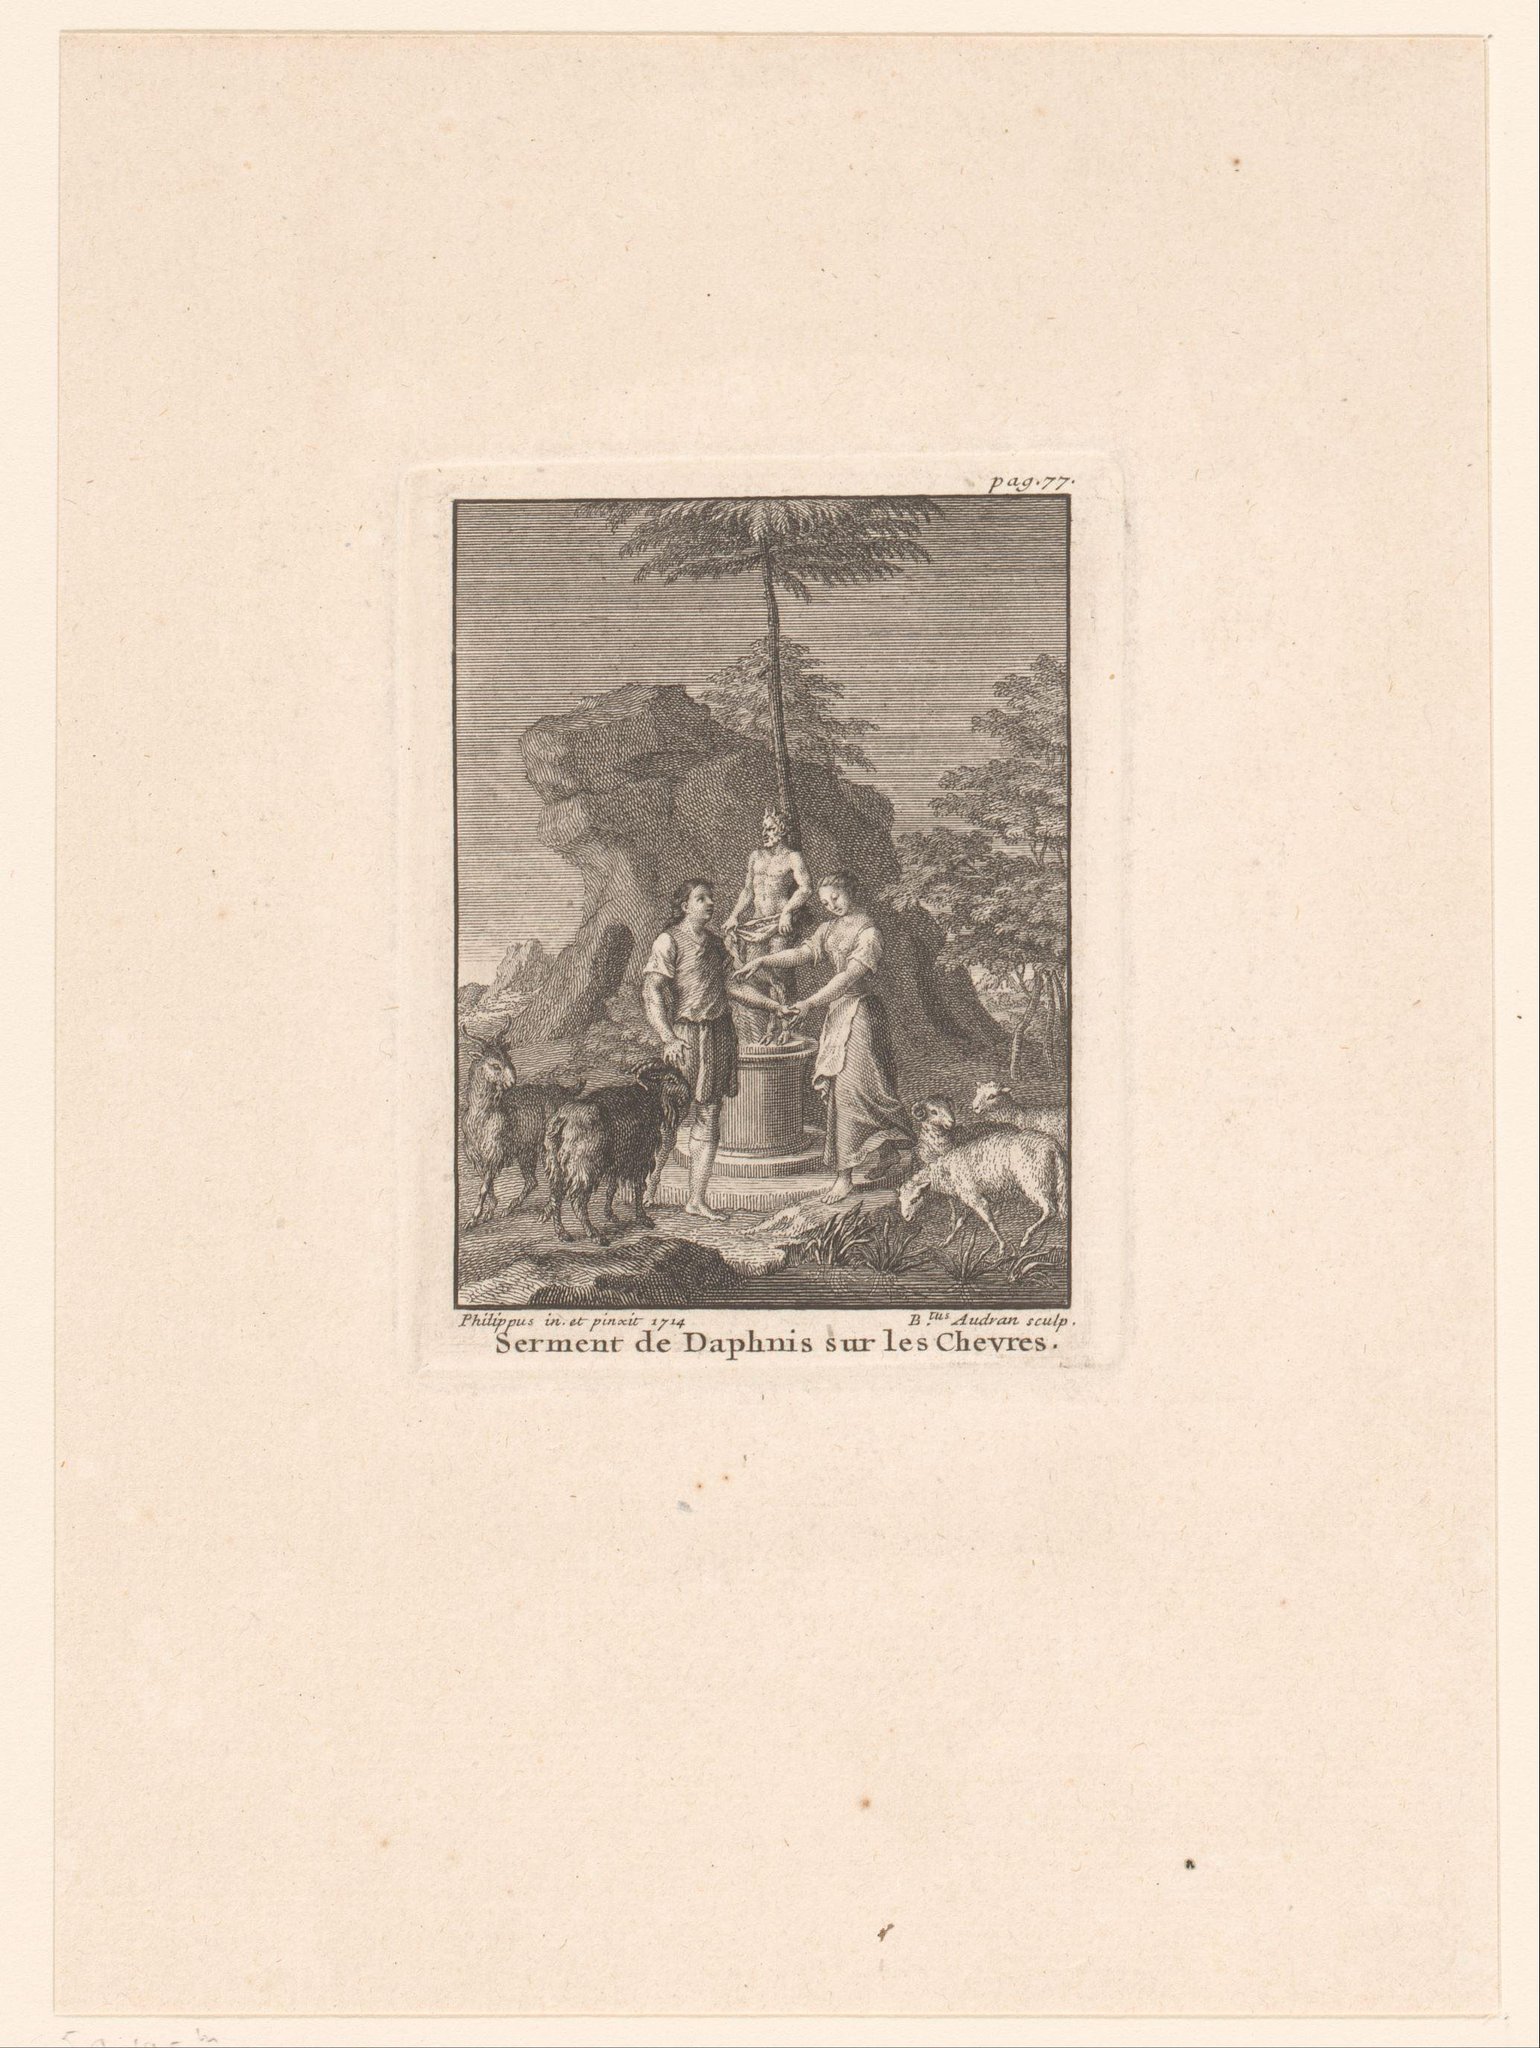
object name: print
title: Serment de Daphnis sur les chevres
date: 1718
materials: paper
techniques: etching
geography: paris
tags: (story of) pan, daphnis (in greek mythology a shepherd who invented pastoral poetry, chloe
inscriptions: collector's mark: Lugt 2760, collector's mark: Lugt 2228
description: Prent uit: Longus. Les amours pastorales de Daphnis et de Chloé, avec figures. Parijs: s.n., 1718.